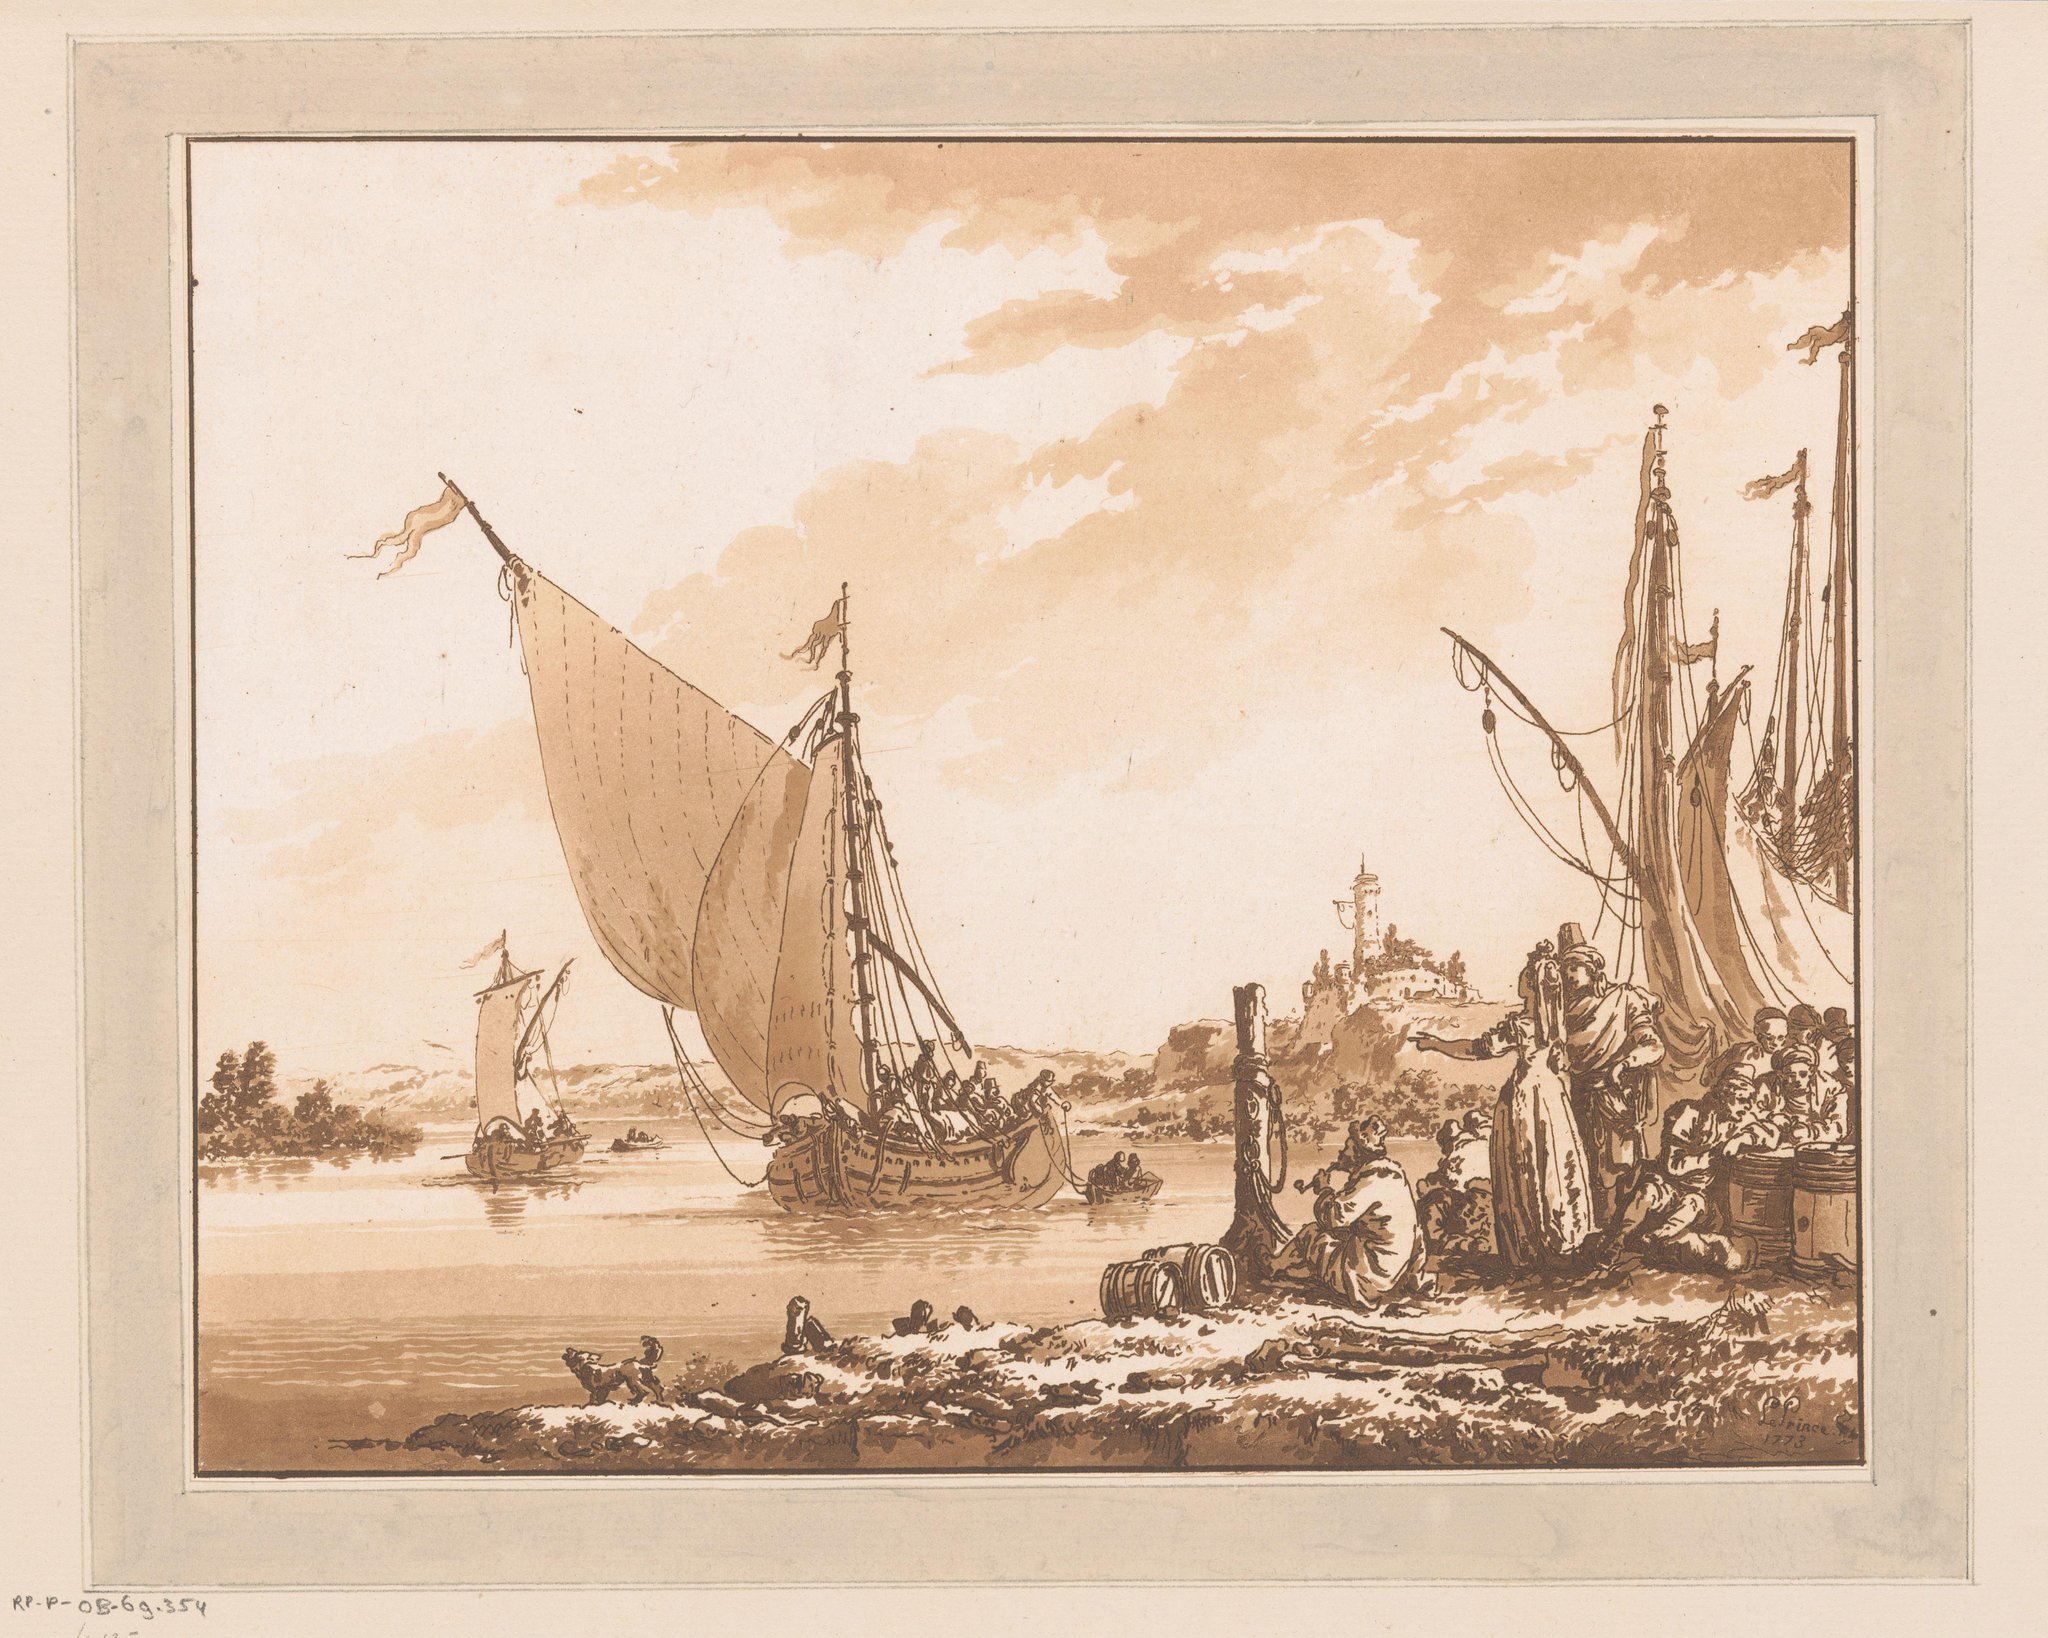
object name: print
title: Kustlandschap met boten en figuren aan wal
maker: jean baptist leprince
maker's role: draughtsman, print maker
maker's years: 1734-1781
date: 1773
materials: paper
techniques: aquatint, etching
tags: coast, boat propelled by man or animal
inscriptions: date